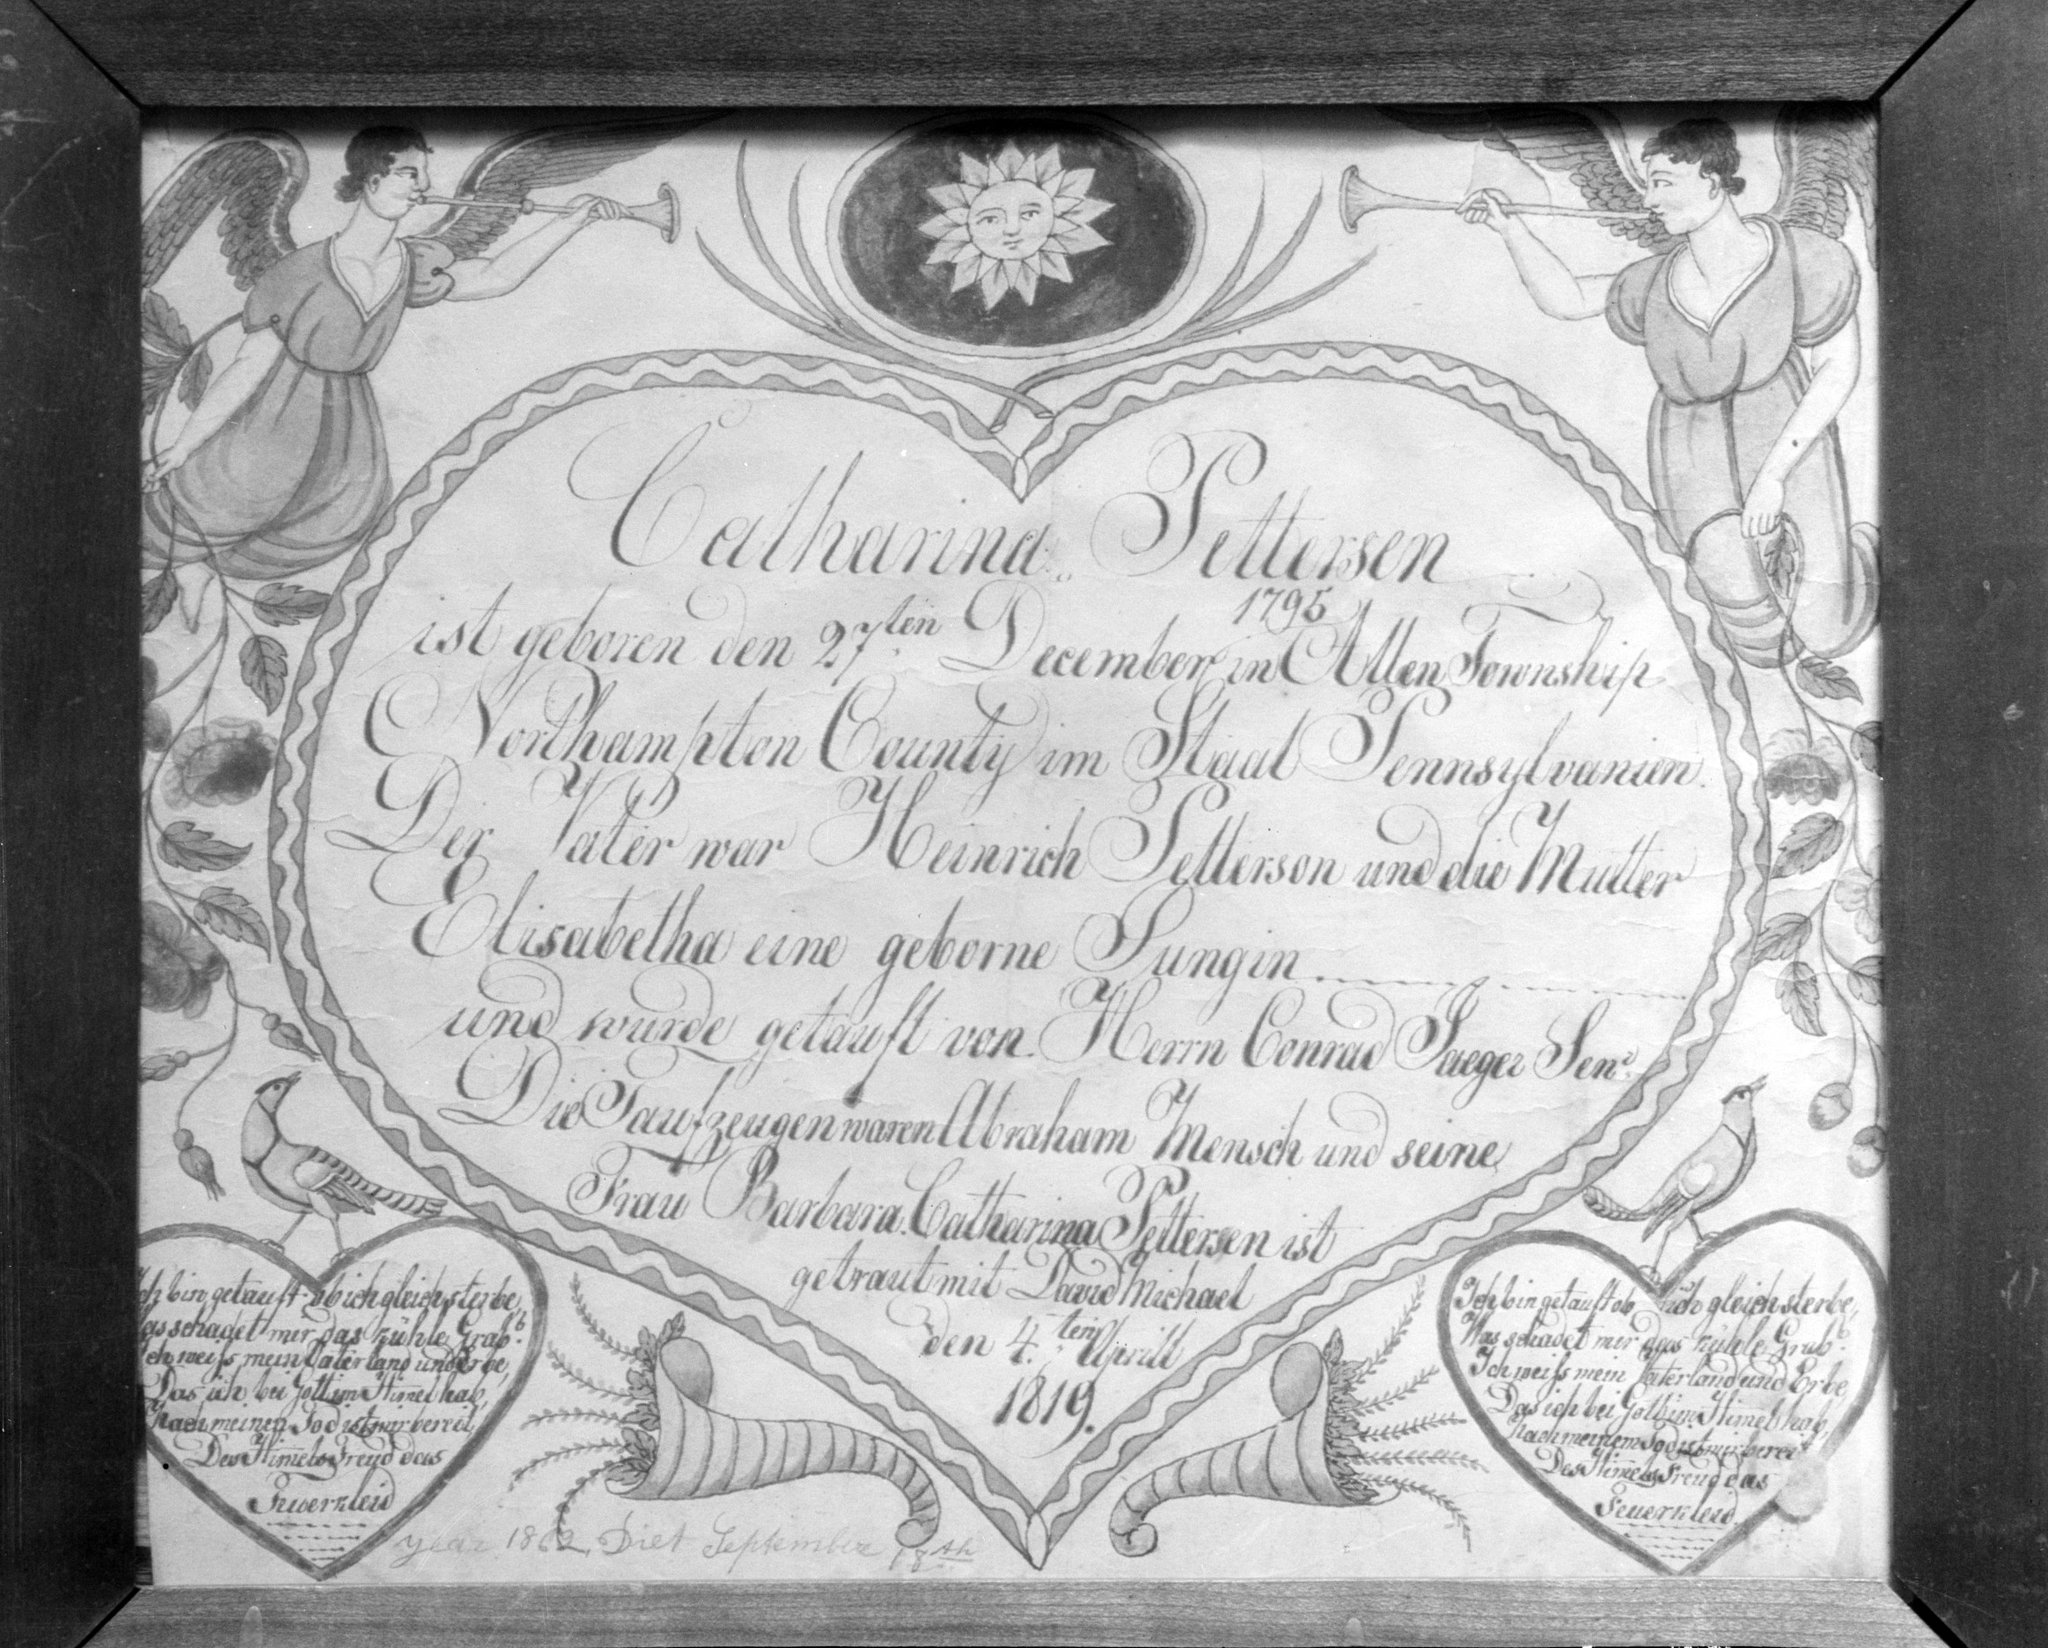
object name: birth and baptismal certificate, fraktur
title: Birth, Baptismal, and Marriage Certificate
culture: american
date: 1819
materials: ink, paper, watercolor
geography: united states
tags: angels